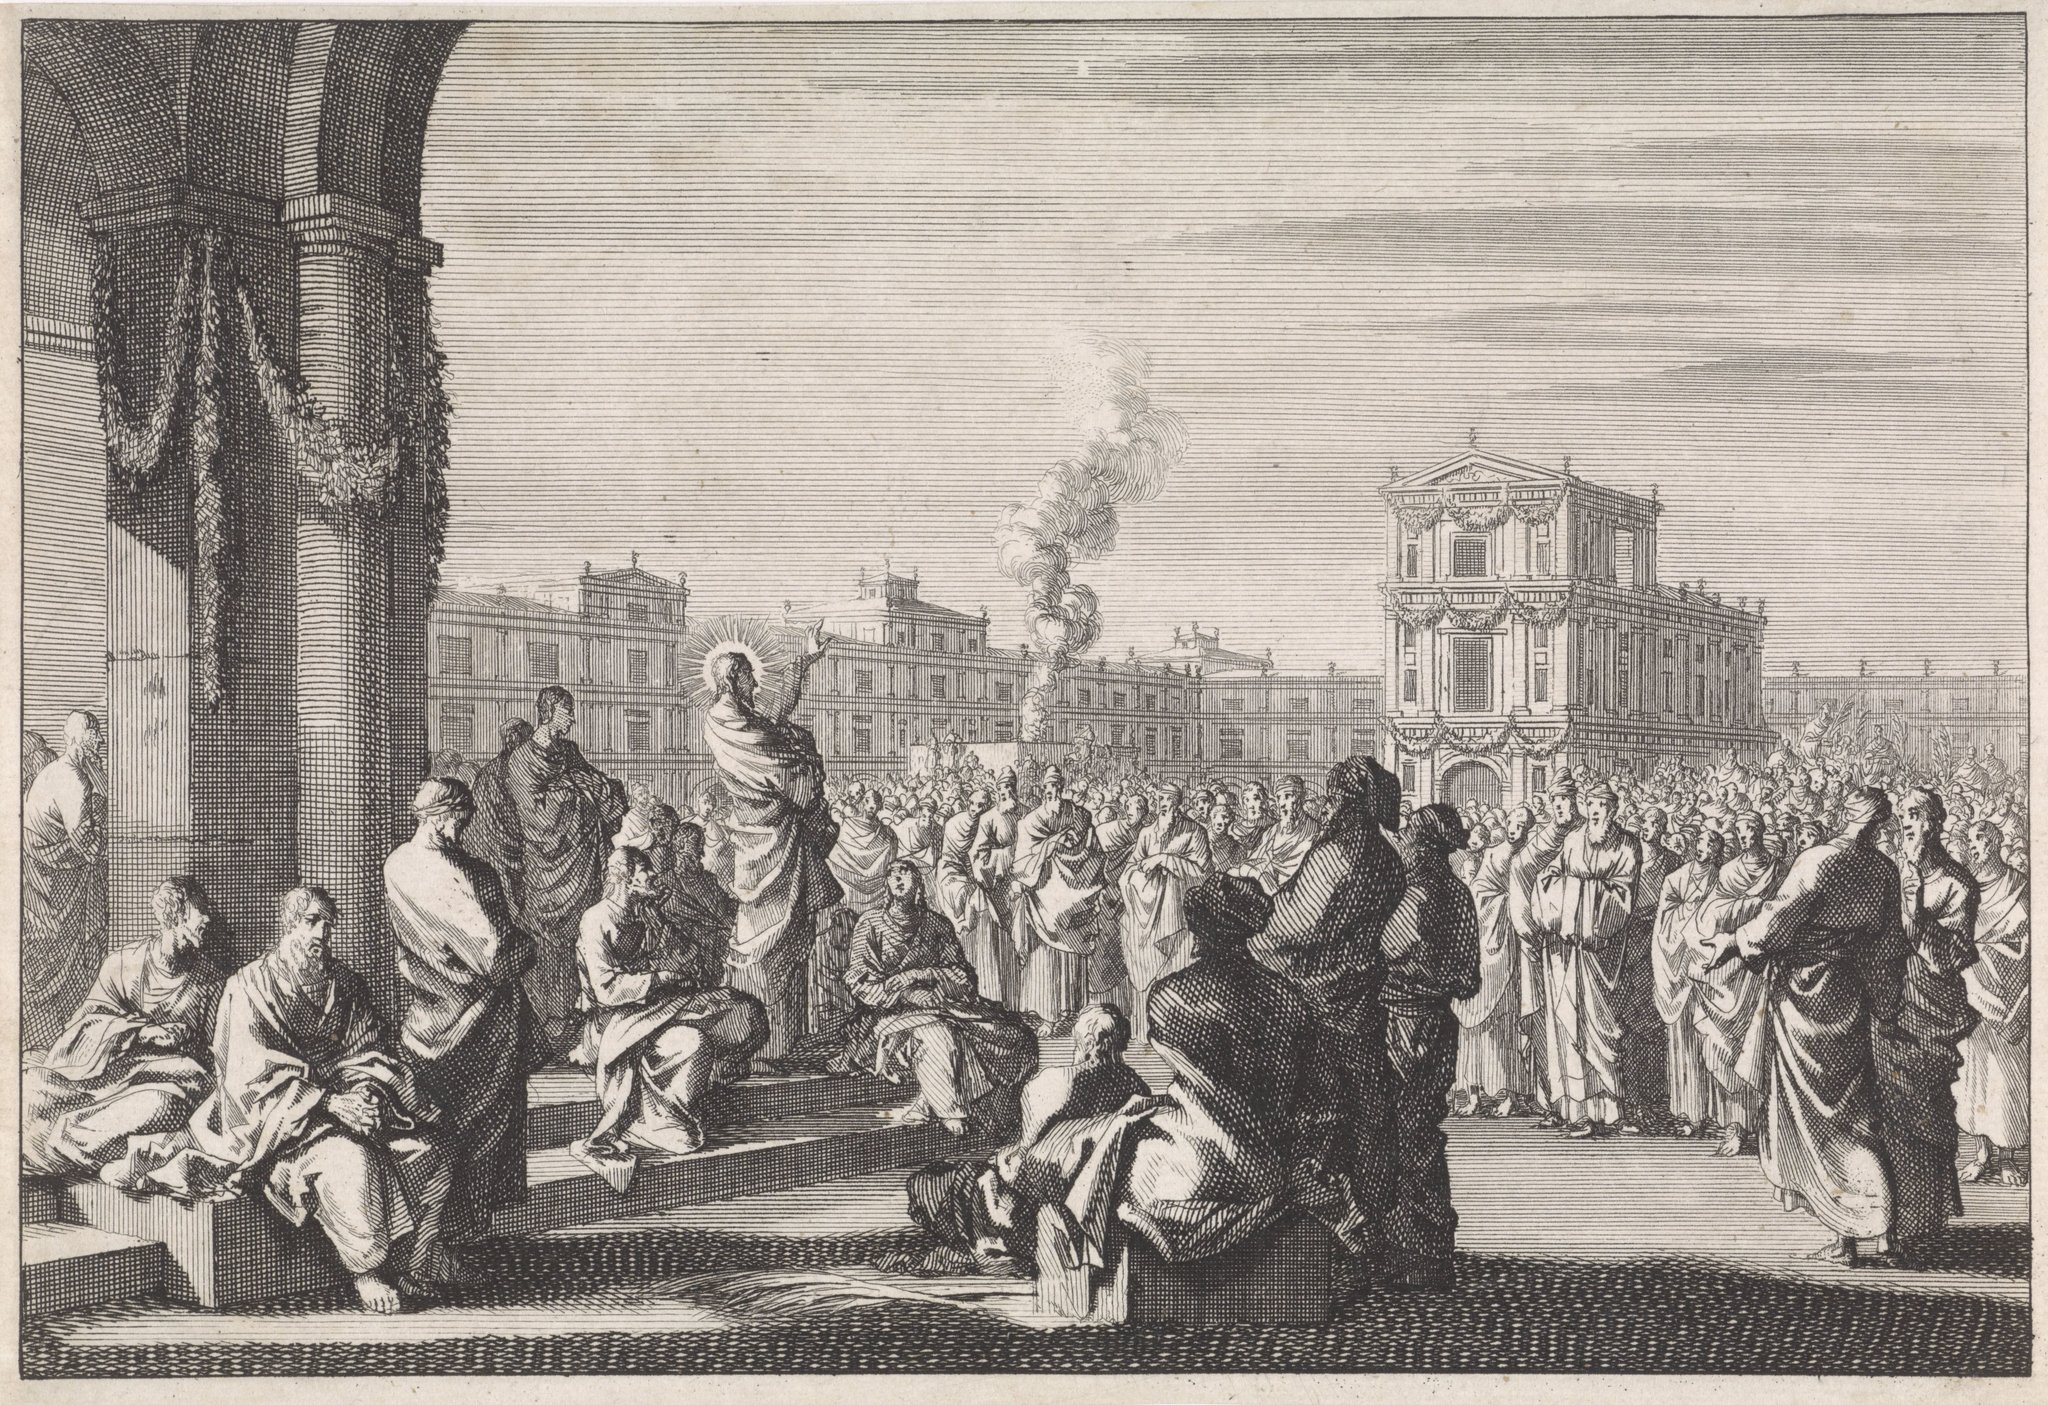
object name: book illustration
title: Preek van Christus voor de tempel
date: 1700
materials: paper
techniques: etching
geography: amsterdam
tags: christ is teaching in the temple in the middle of the feast of tabernacles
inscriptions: collector's mark: Lugt 2228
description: Boekillustratie voor David Martin. Historie des Ouden en Nieuwen Testaments, verrykt met meer dan vierhonderd printverbeeldingen. Deel II. Amsterdam: Pieter Mortier, 1700.